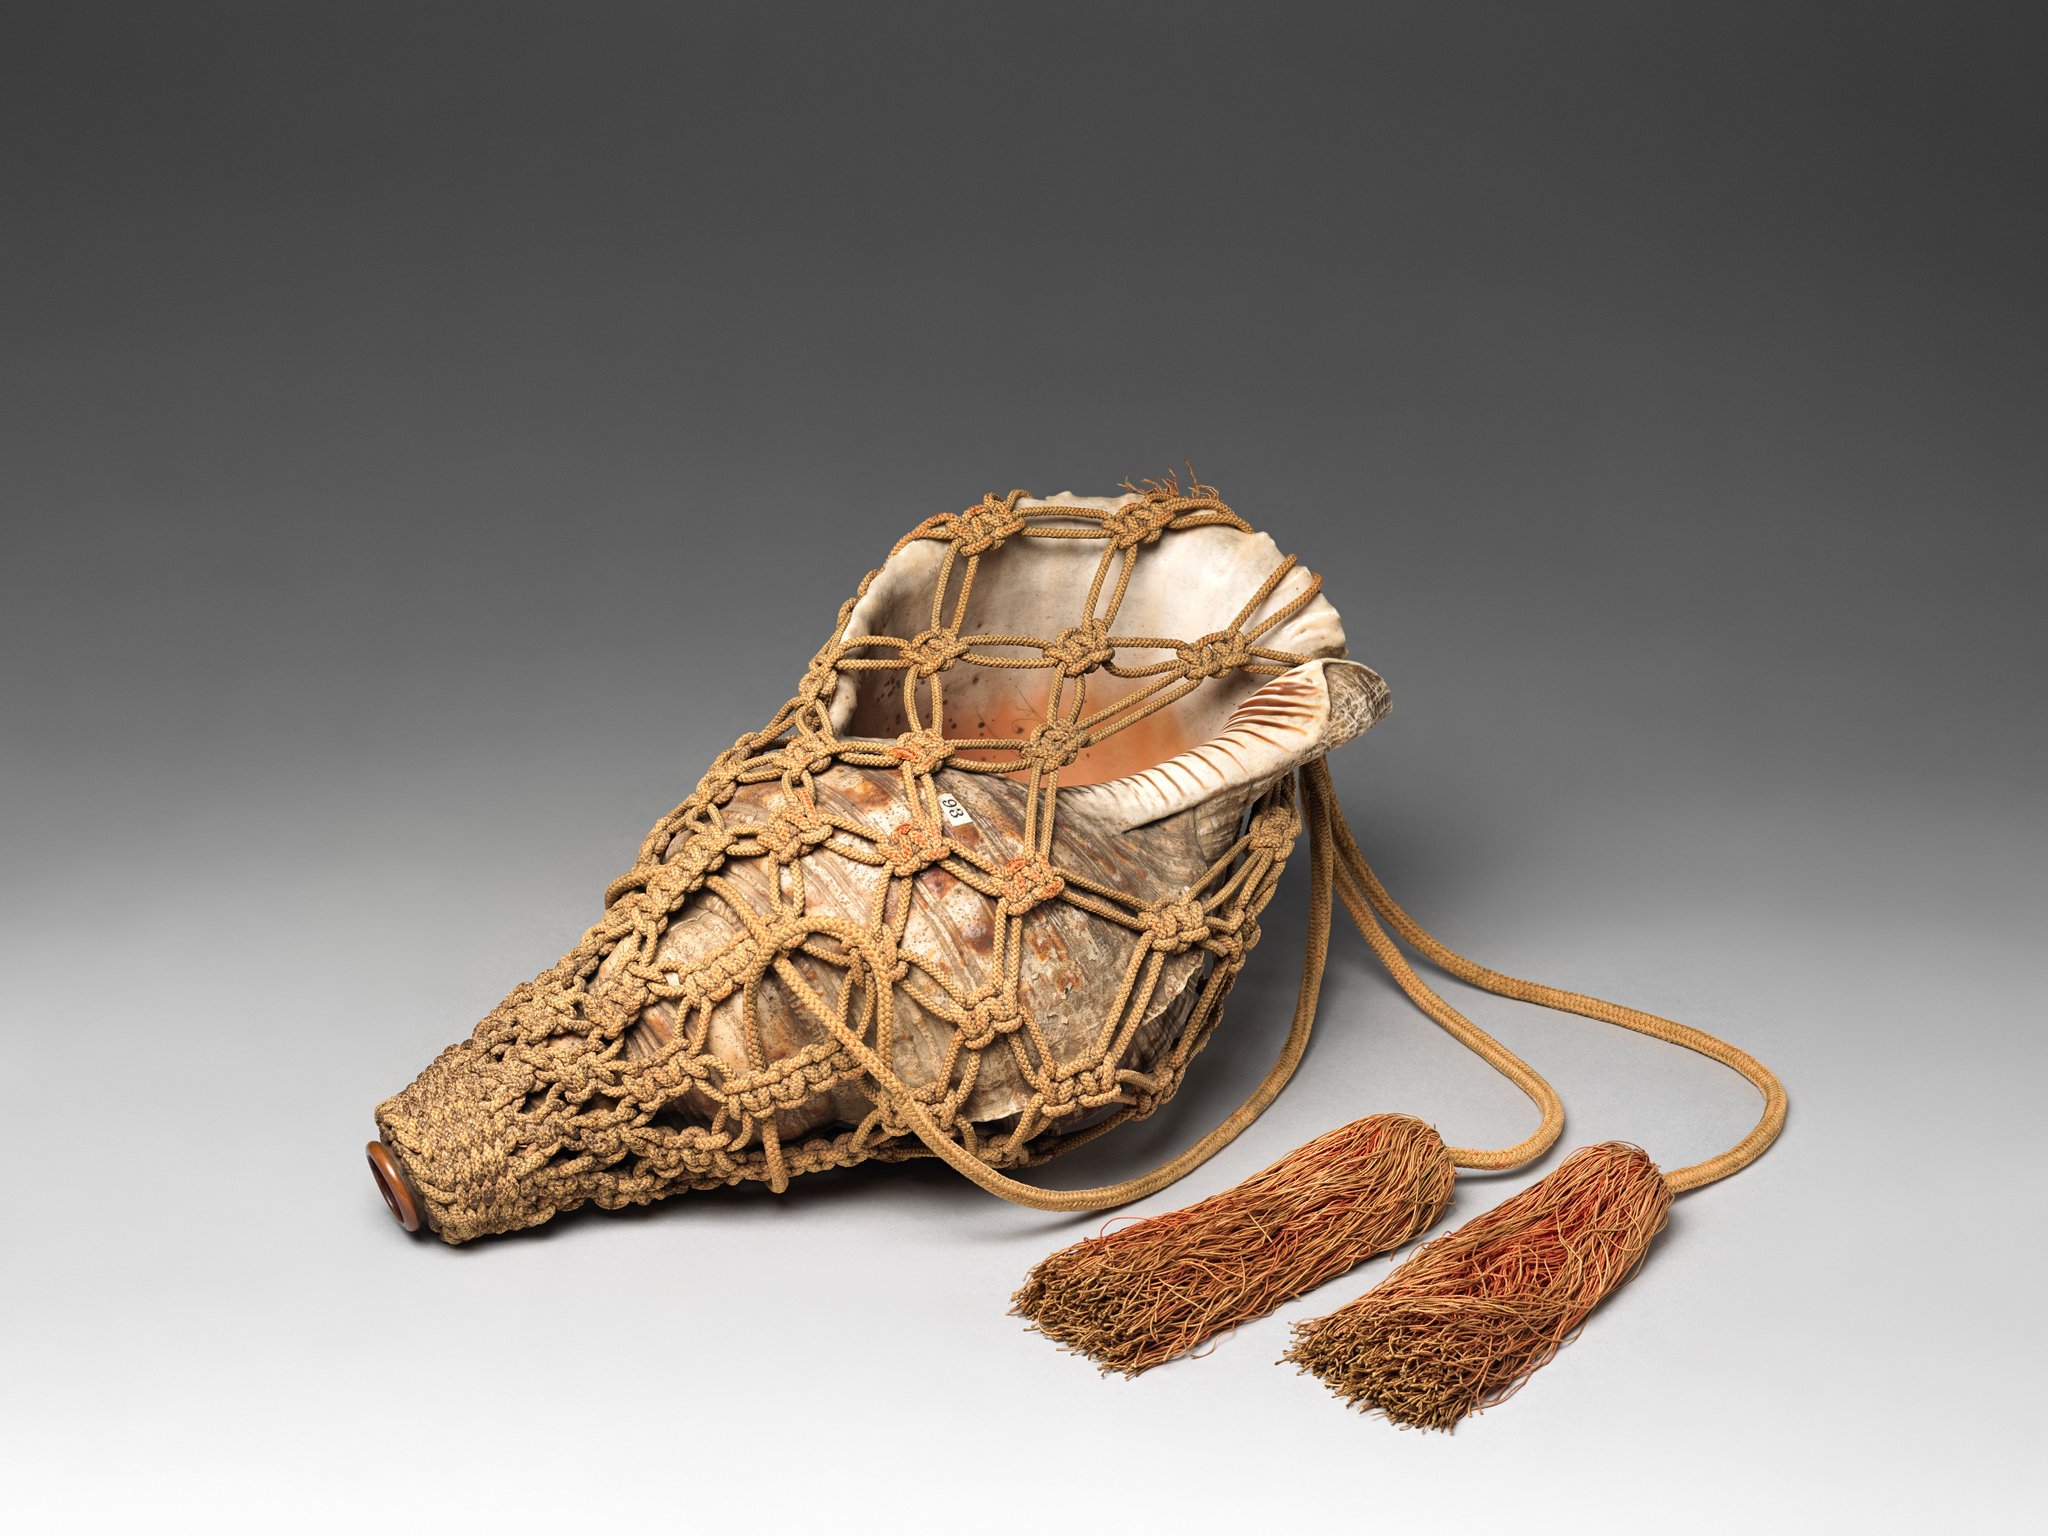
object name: horagai or rappakai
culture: japanese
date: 1801-1900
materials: shell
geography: japan